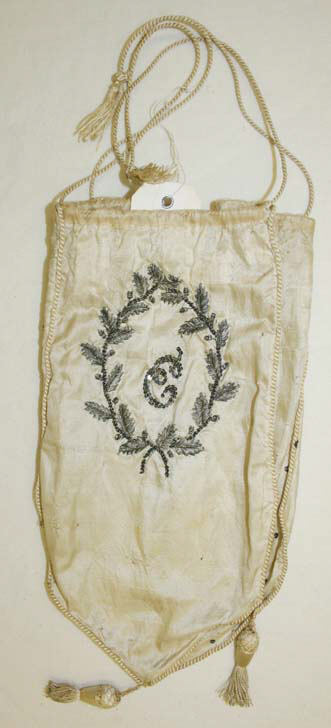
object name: purse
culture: european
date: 1800-1810